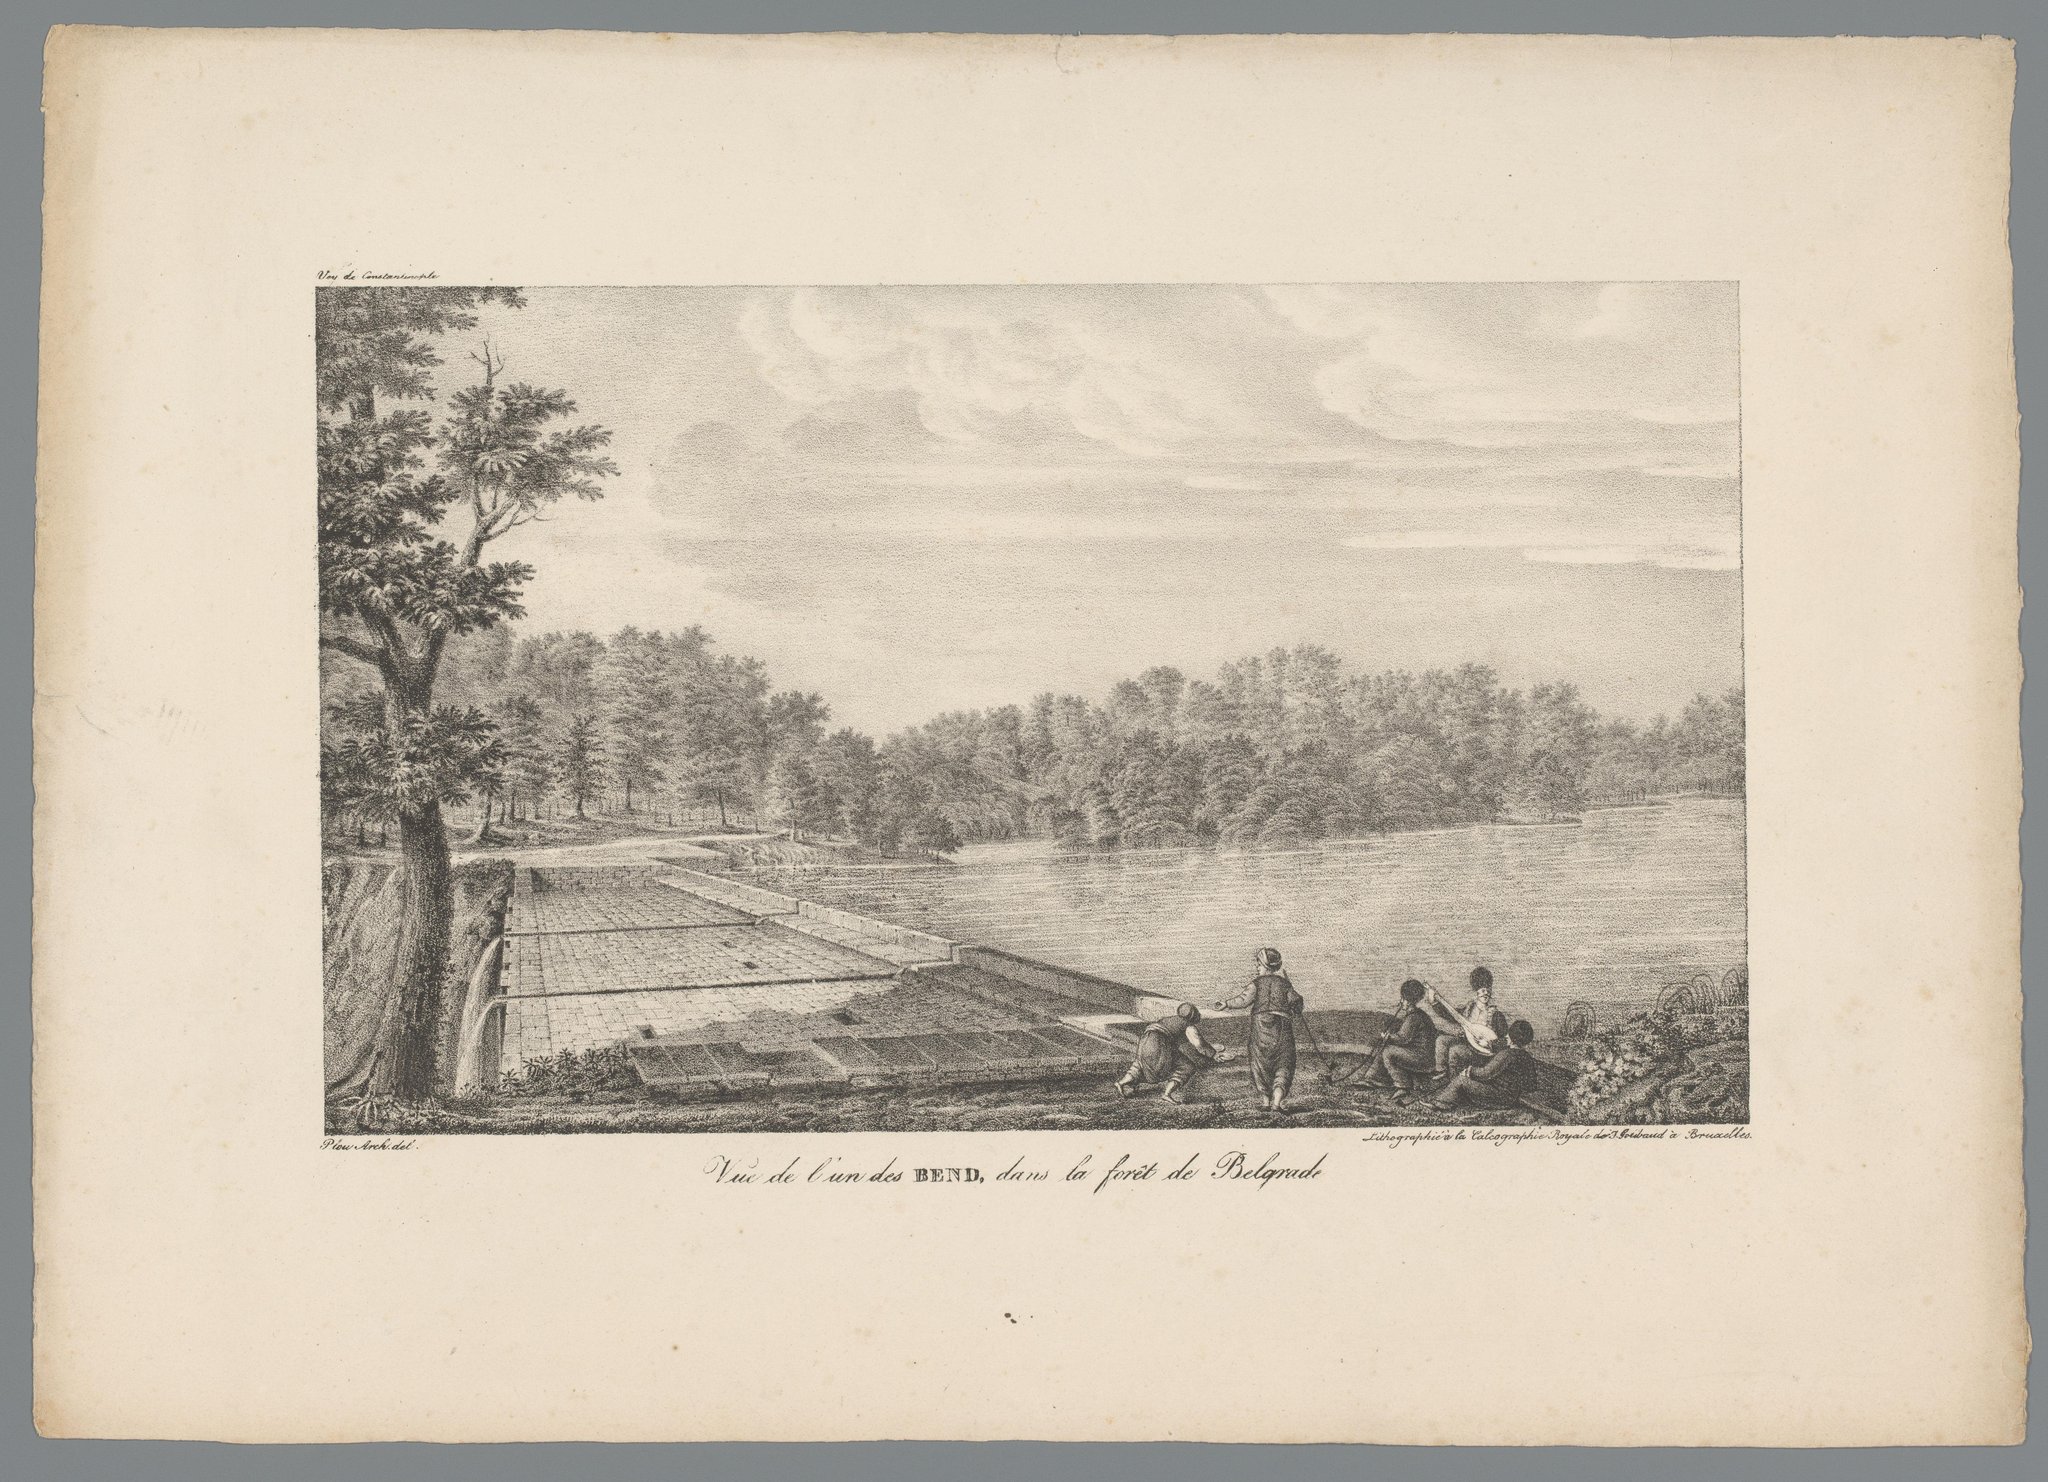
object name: print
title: Vue de l'un des Bend, dans la forêt de Belgrade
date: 1822-1828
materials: paper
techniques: lithograph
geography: brussels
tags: river, forest, wood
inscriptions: collector's mark: Lugt 2228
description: Prent verschenen in: Barbié du Bocage, Jean Denis. Voyage pittoresque de Constantinople et des rives du Bosphore. Brussel: Innocent Louis Goubaud, 1822-1828. Deze publicatie bevat 48 litho's, die in afleveringen verschenen als illustratie bij de tekst.